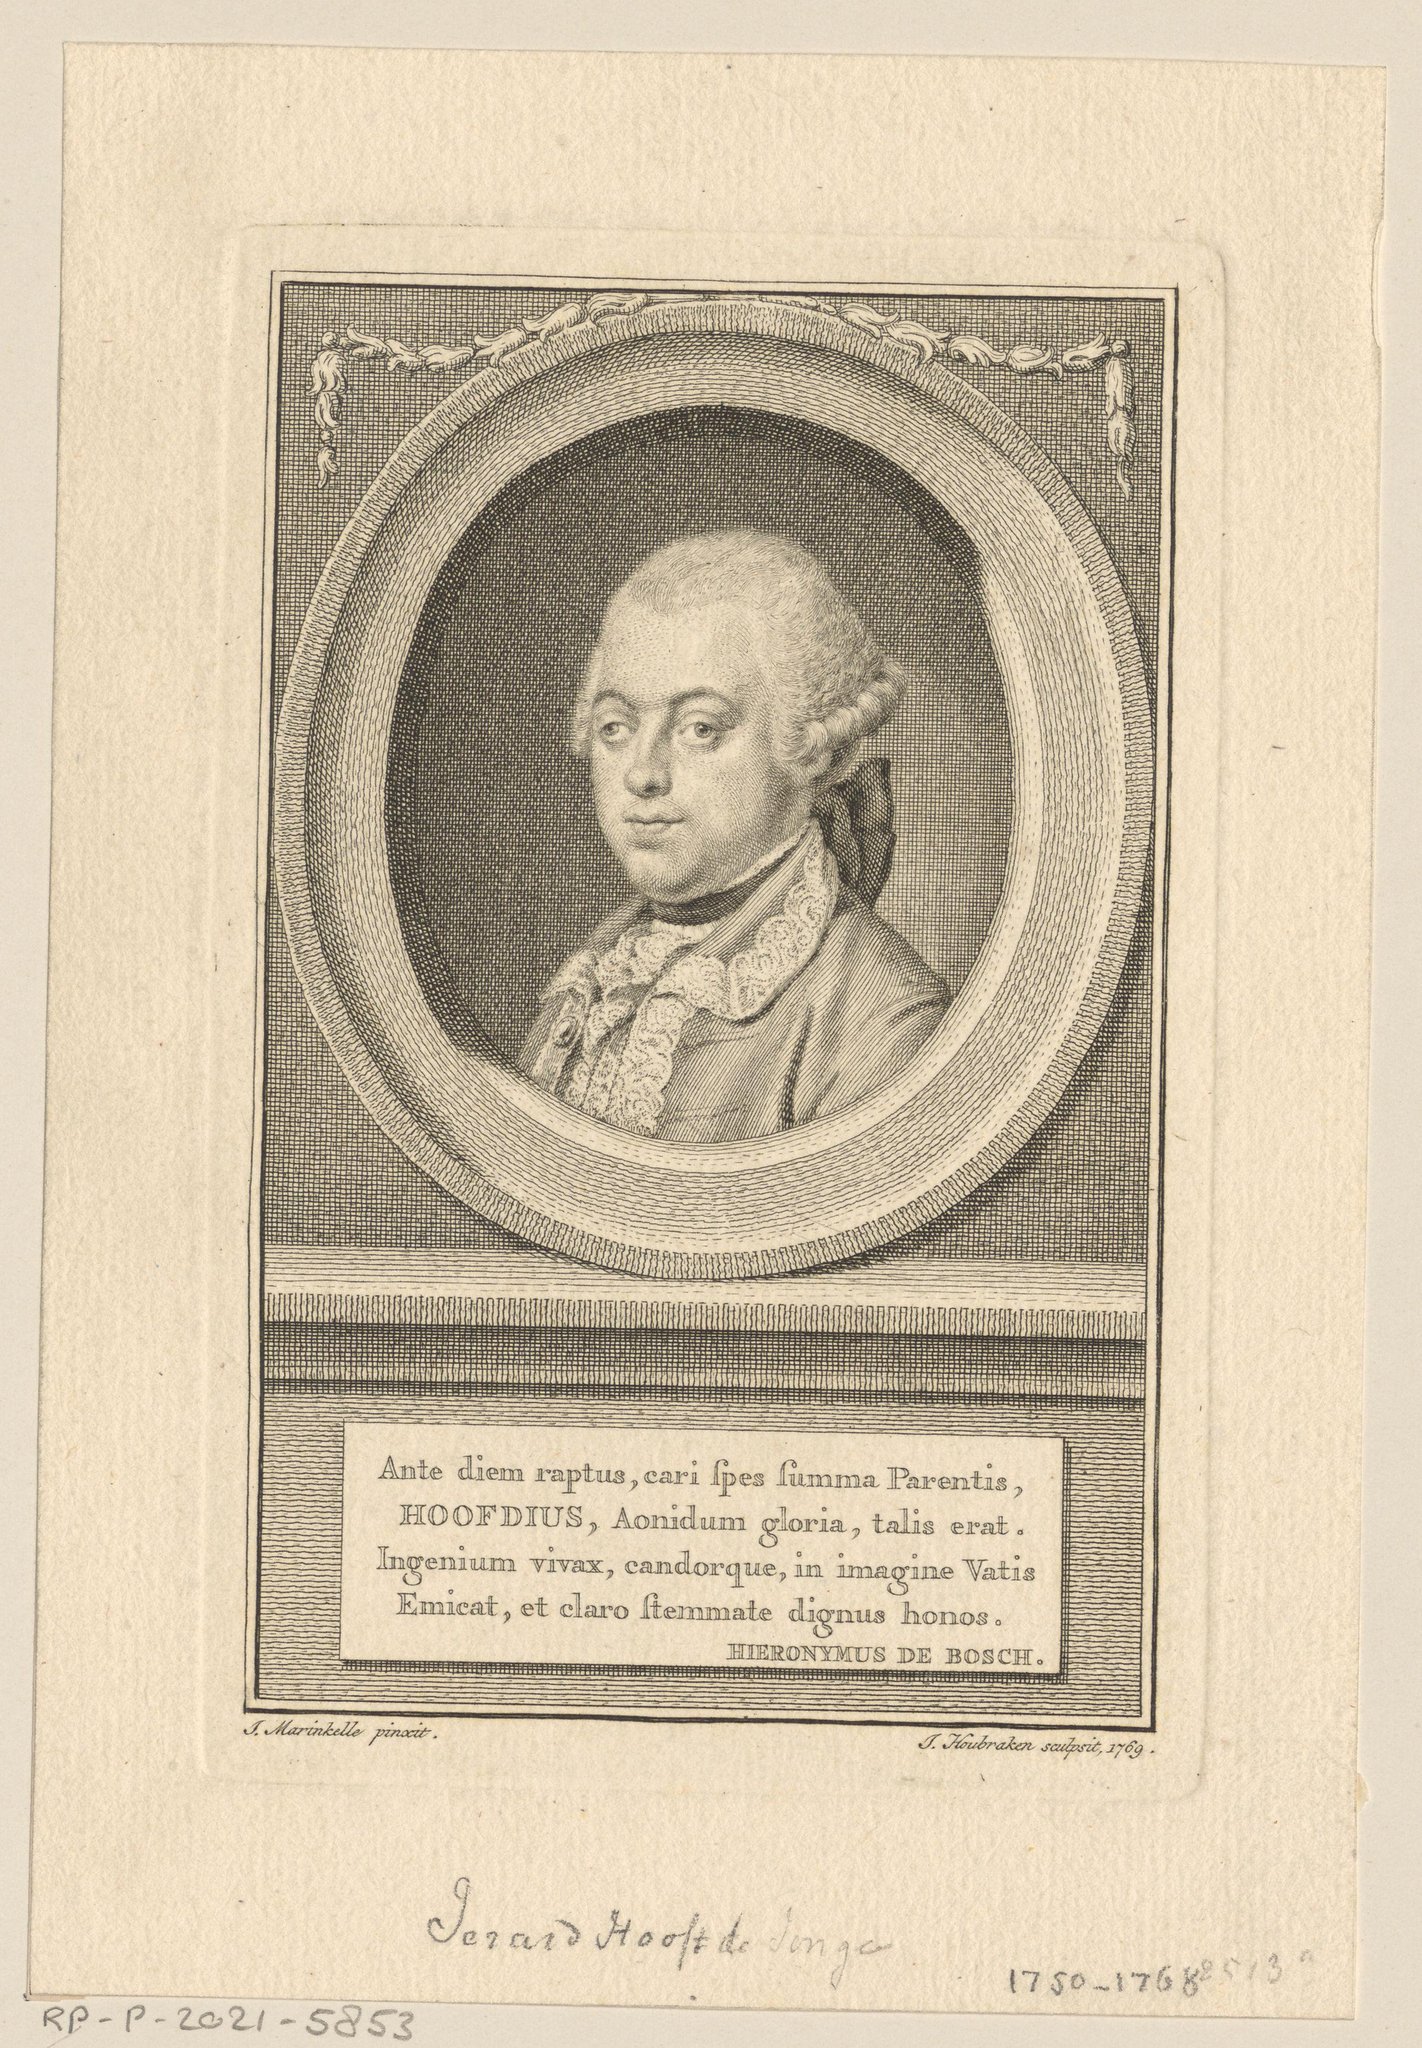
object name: print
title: Portret van Gerrit Hooft II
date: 1769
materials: paper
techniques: engraving, etching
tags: historical persons, writer, poet, author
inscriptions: date